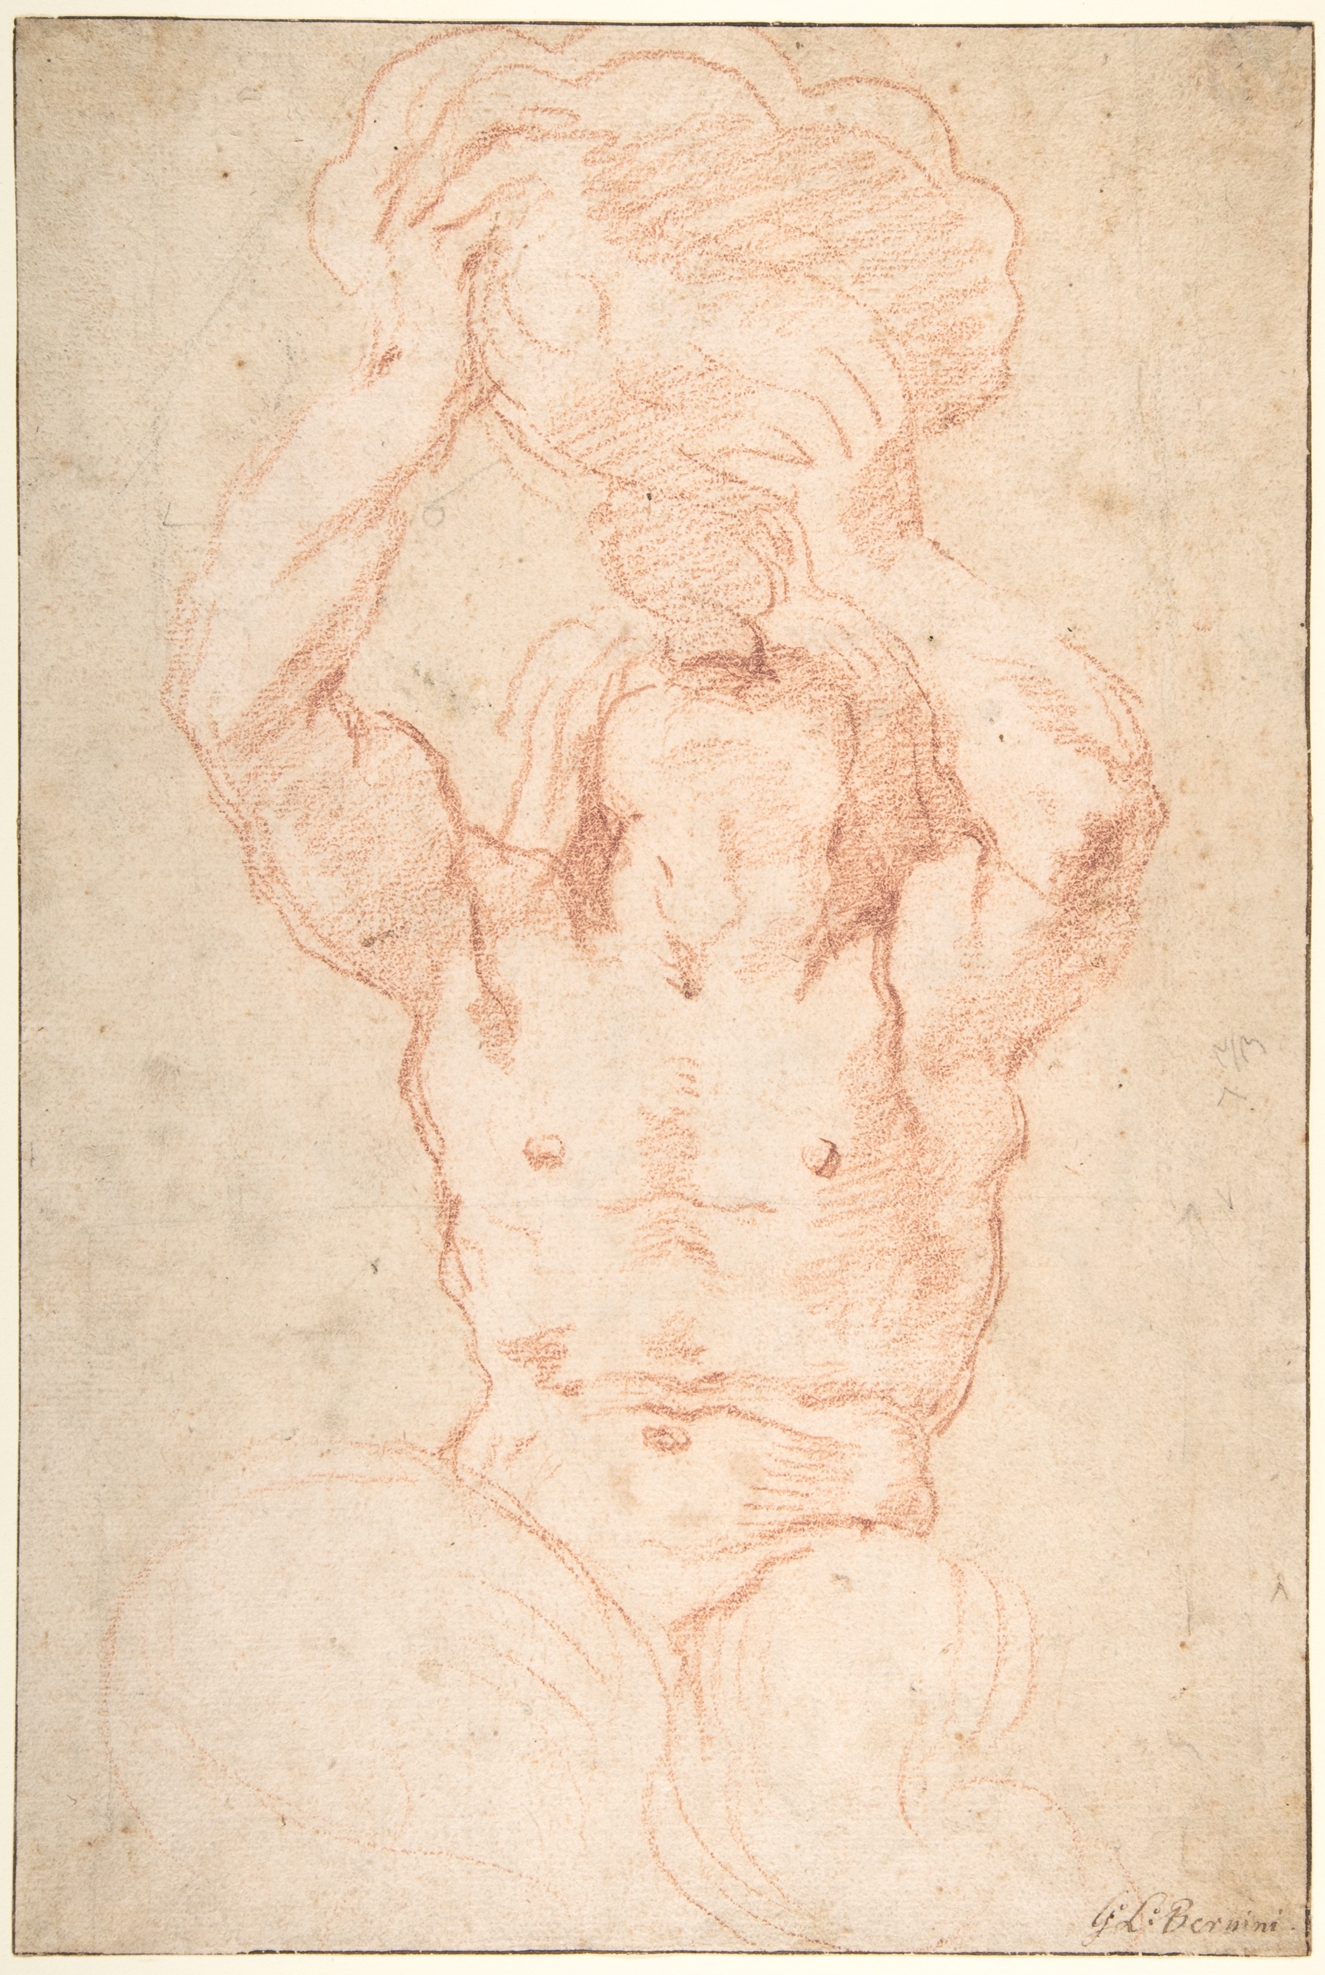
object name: drawing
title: Study for a Triton (recto); Anatomical Studies ? (verso)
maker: gian lorenzo bernini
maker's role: artist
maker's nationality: italian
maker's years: 1598-1680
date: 1642-1643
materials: chalk, ink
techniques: pen, tinting, wash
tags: triton,drinking